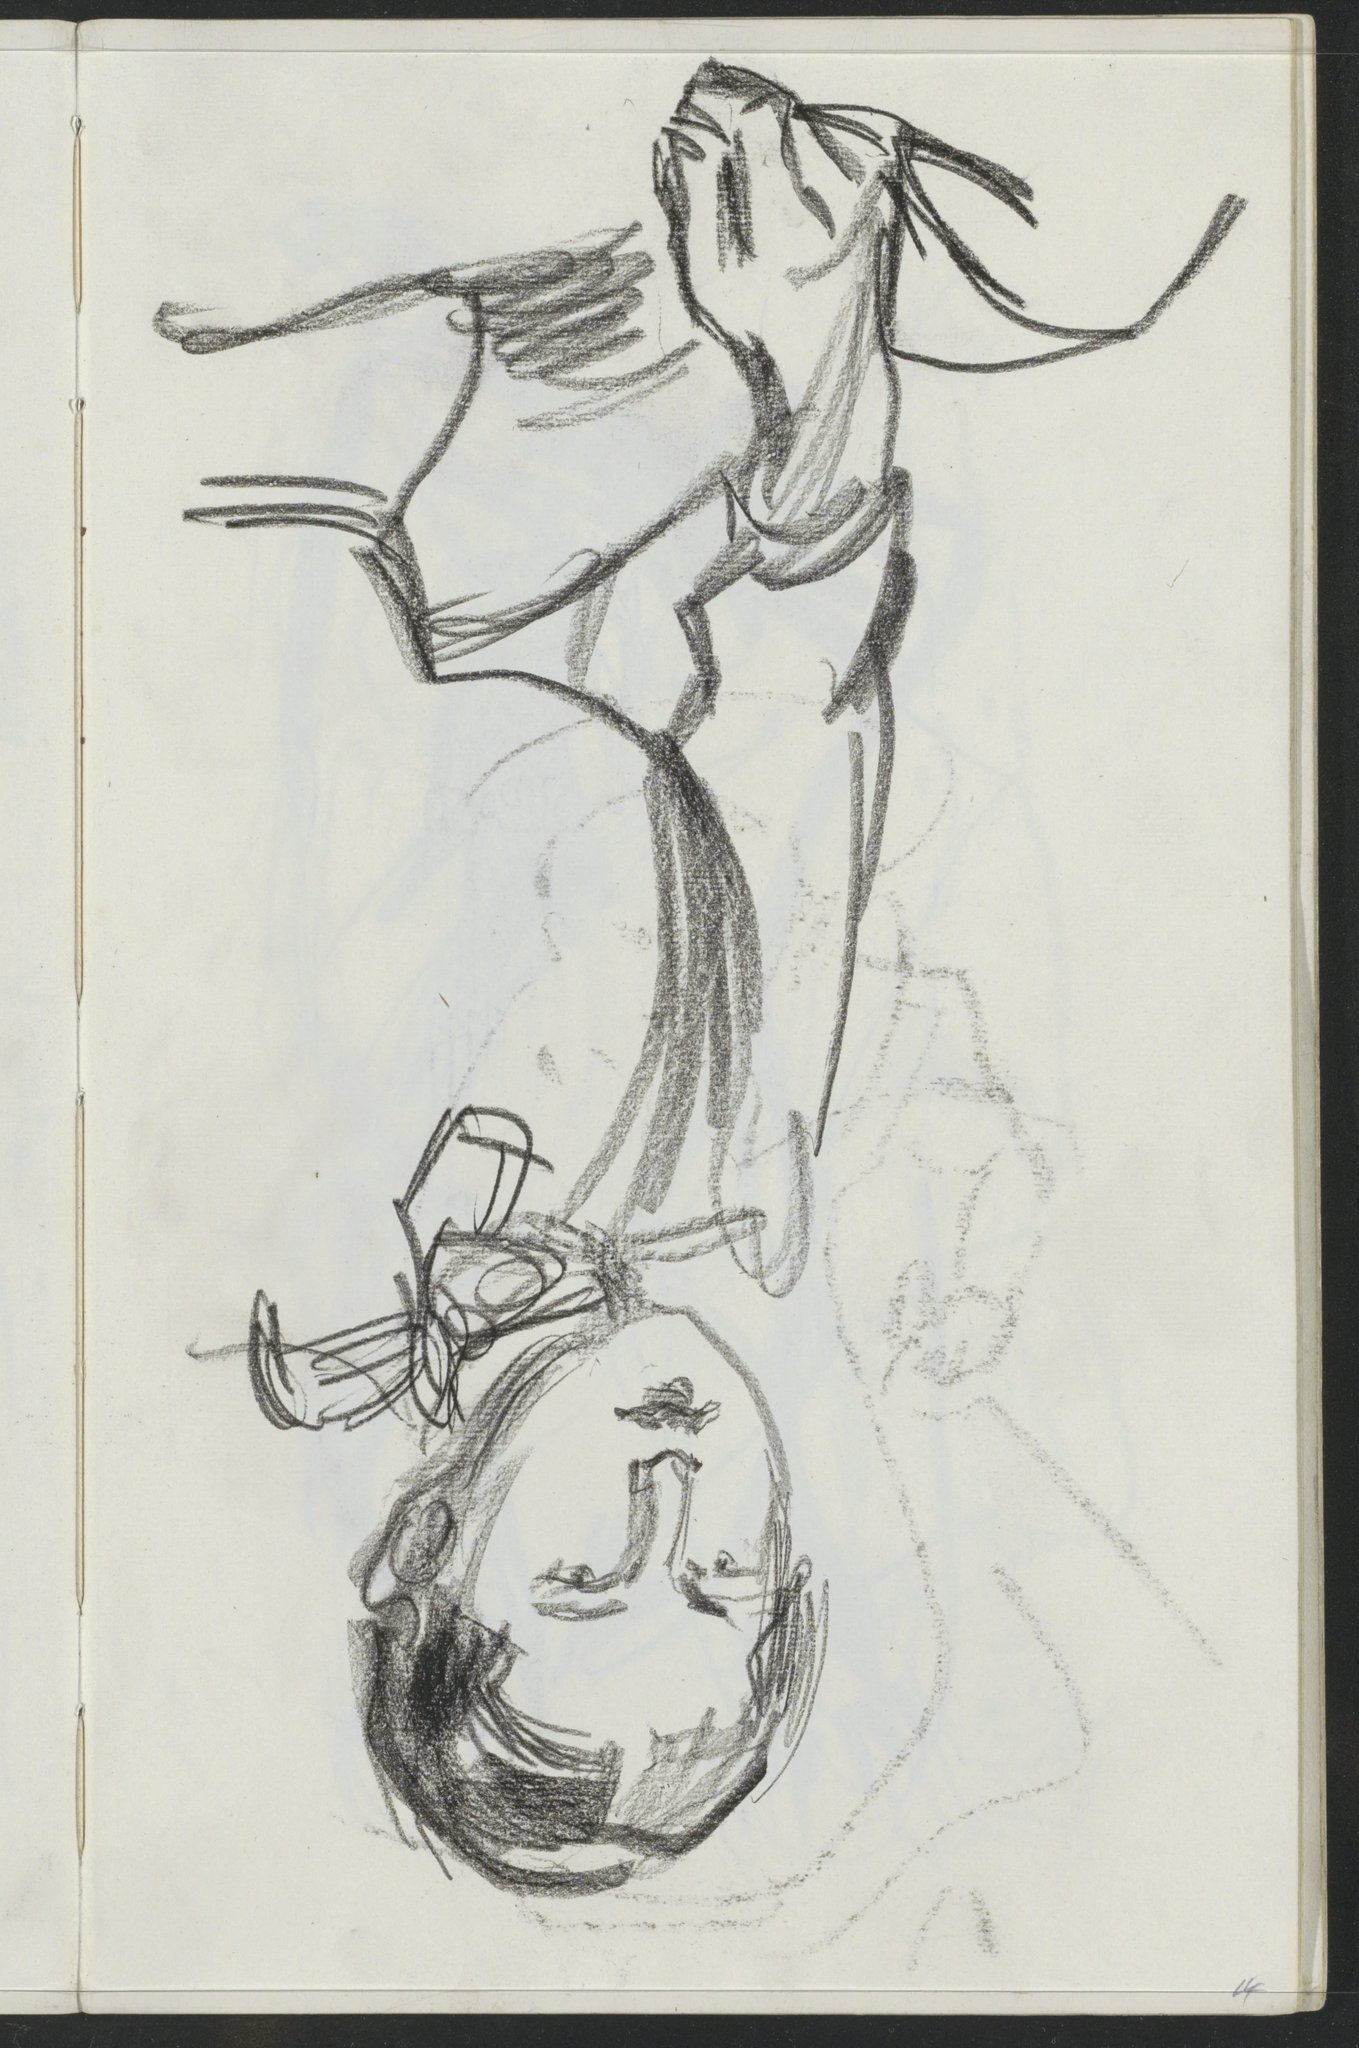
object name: sketchbook leaf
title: Zittende vrouw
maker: isaac israels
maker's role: draughtsman, painter, print maker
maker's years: 1865-1934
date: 1875-1934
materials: chalk, paper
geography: amsterdam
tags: adult woman (+ sitting)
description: Blad 14 recto uit schetsboek XI met 30 bladen.